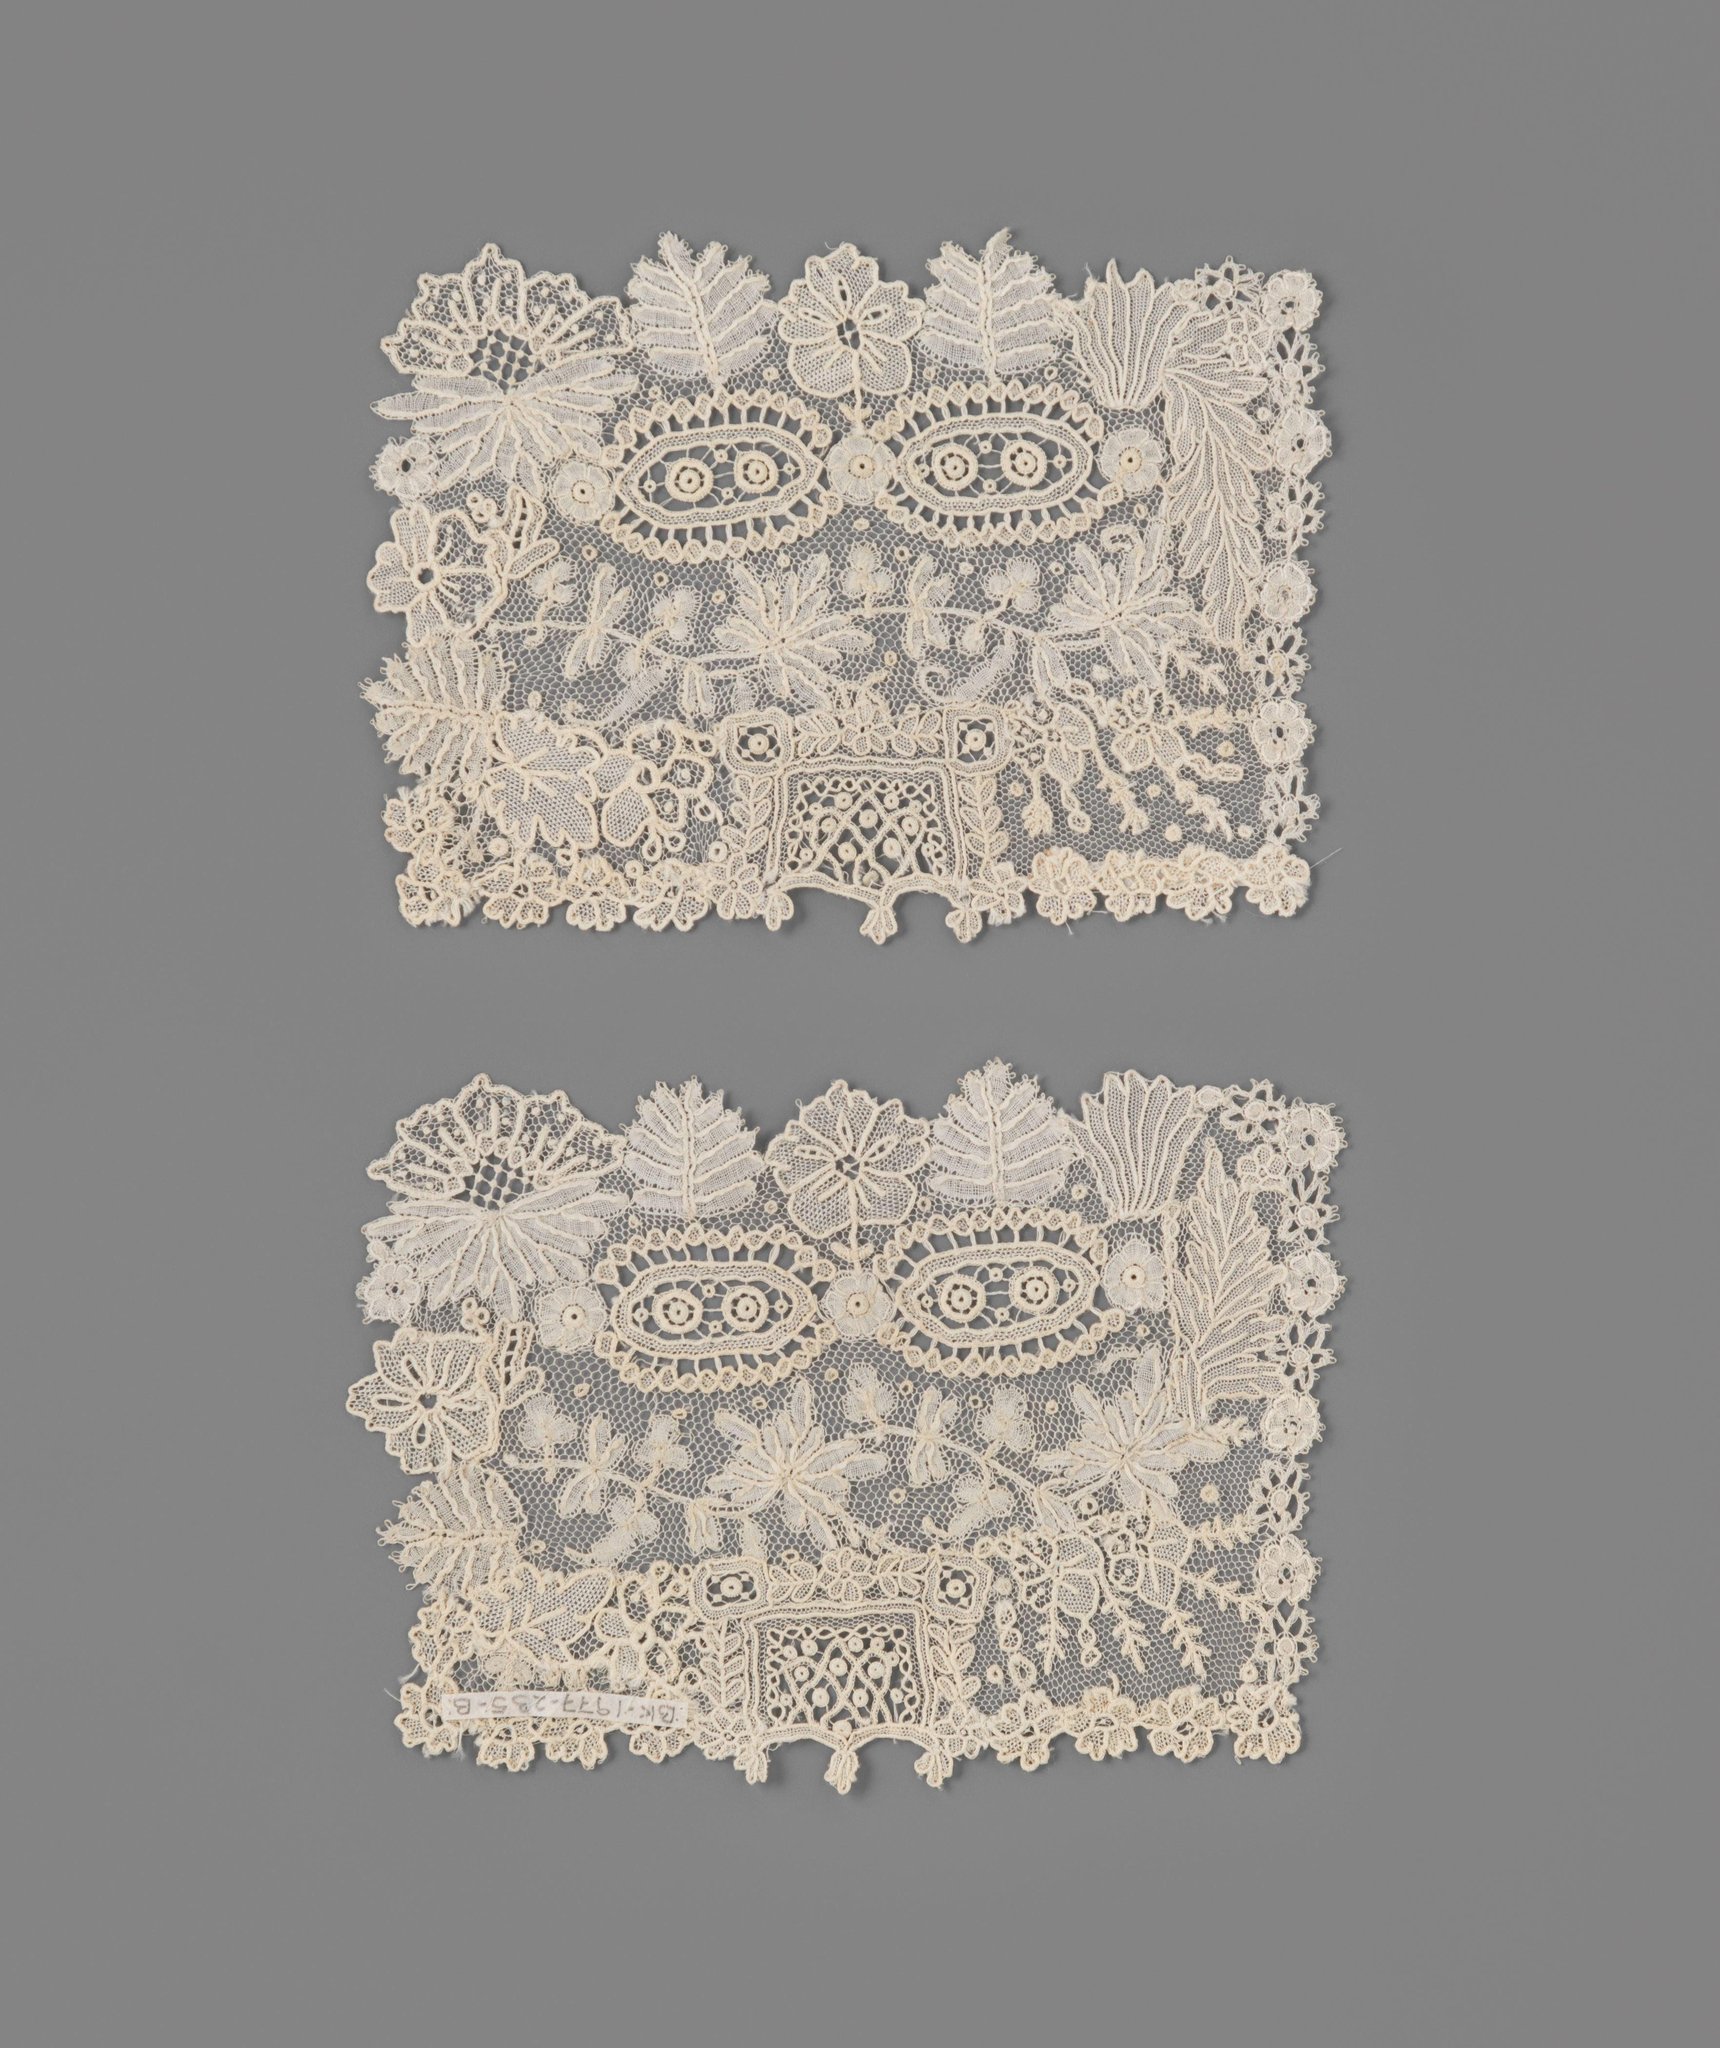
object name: dasslip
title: Dasslip van een strikdas in Point de gaze de Bruxelles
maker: Anonymous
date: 1870-1880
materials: lace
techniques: lace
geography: brussels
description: Dasslip van een strikdas in Point de gaze de Bruxelles, rechthoekig van vorm en onregelmatig geschulpt. Het patroon heeft bij de aanzet een rechthoekig medaillon en aan de onderzijde twee ovalen. Langs de gepicoteerde randen heeft het patroon bloemen en gevederde bladen; in het midden een rank. De decoratie is voorzien van verdikte contourdraden.